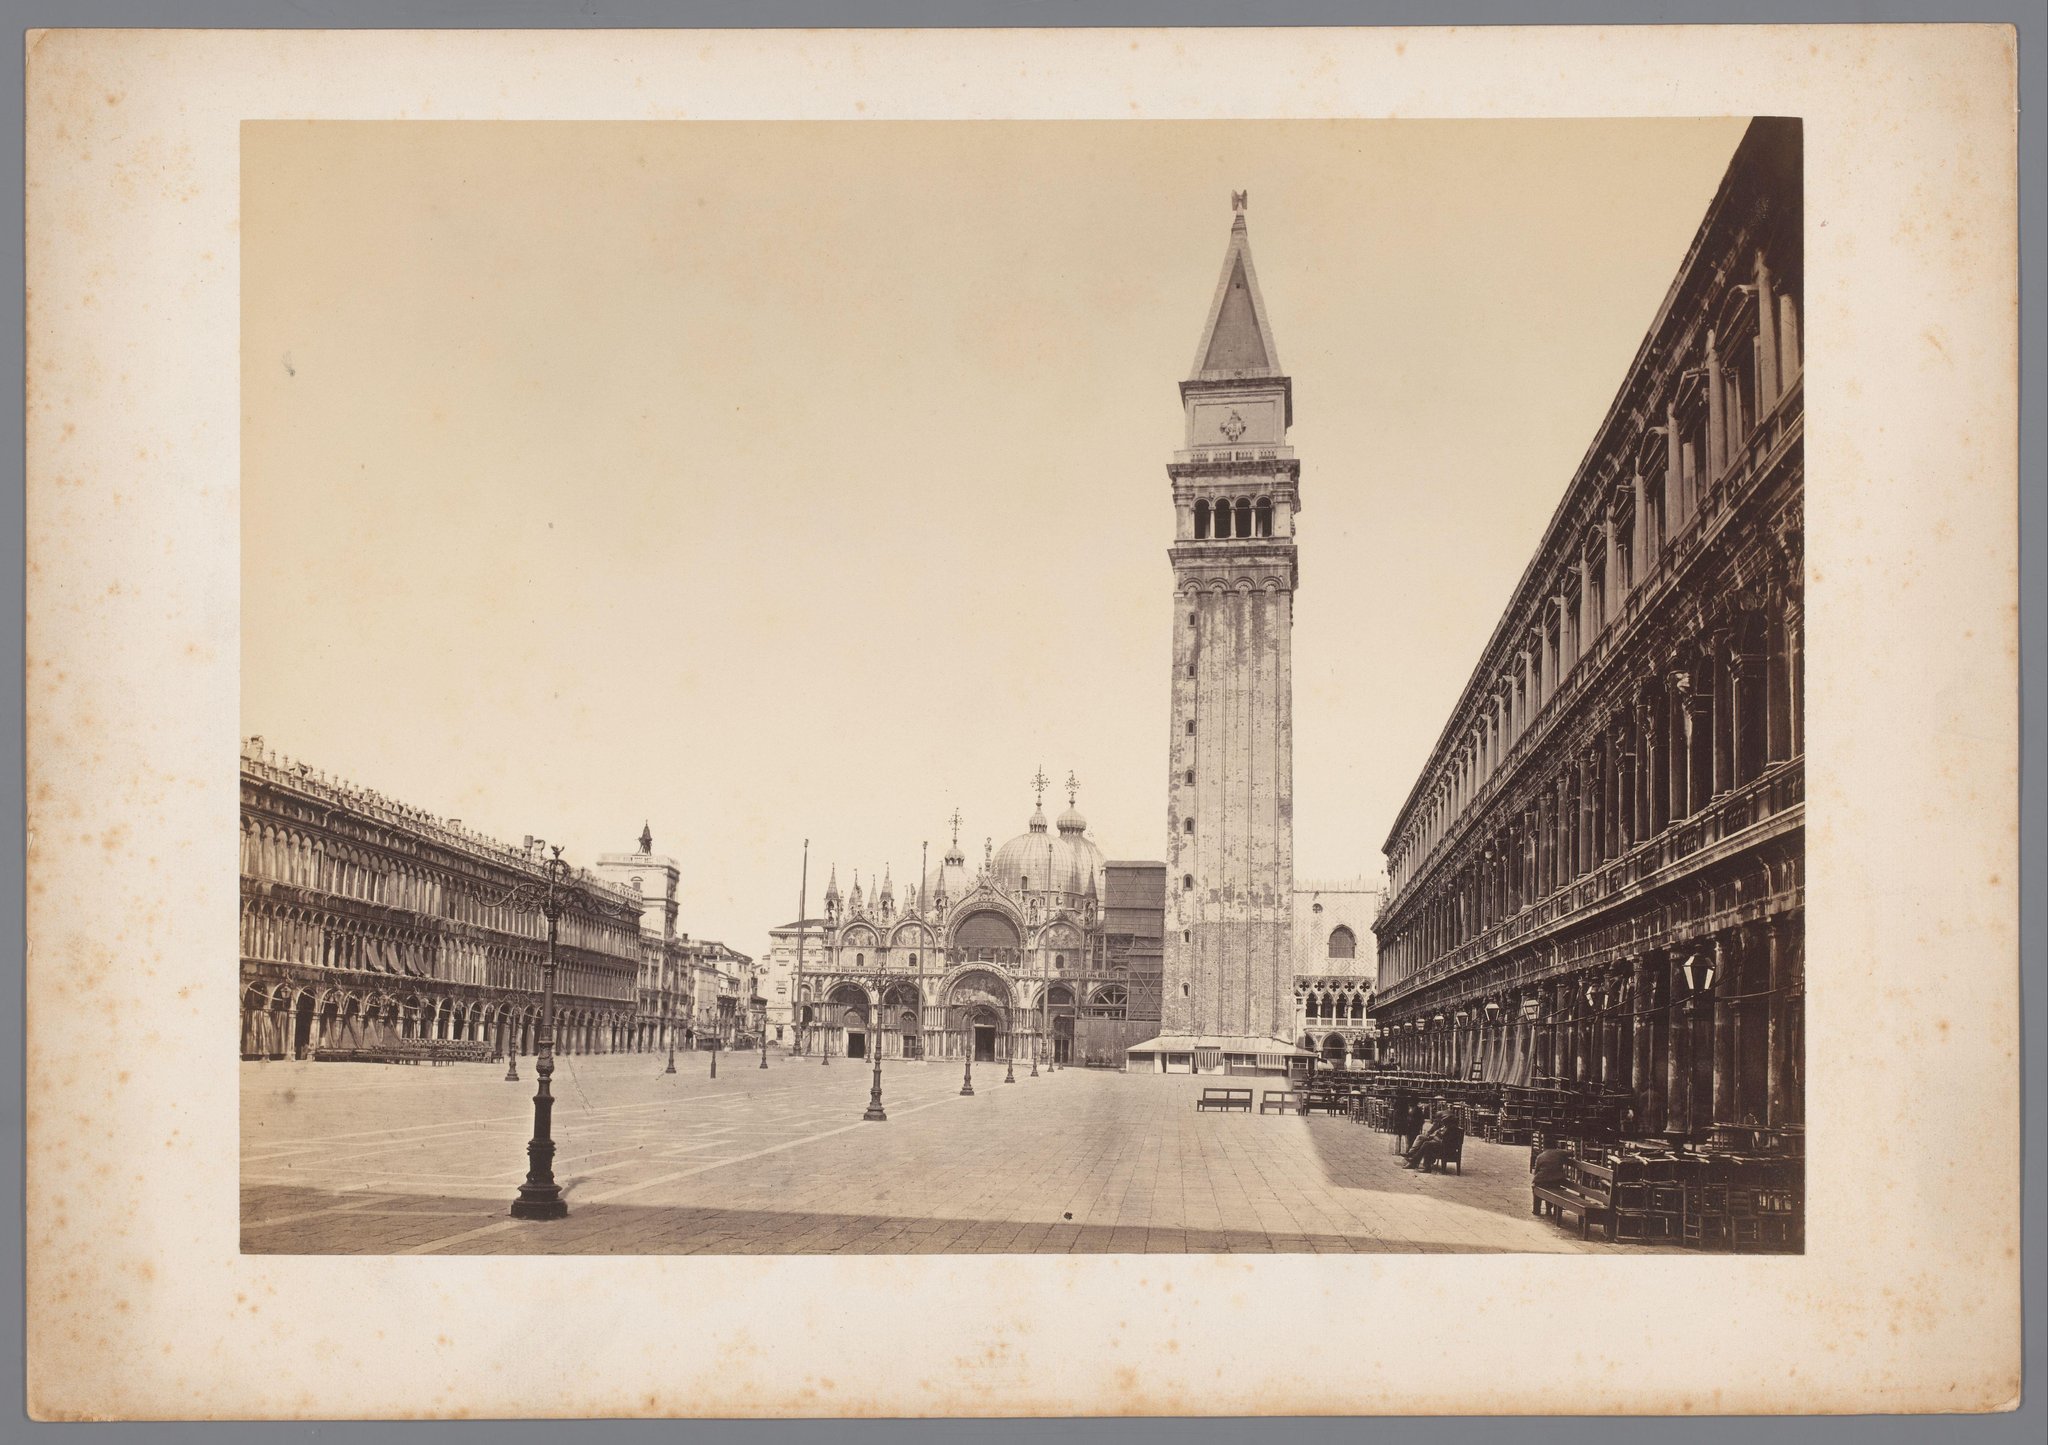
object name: photograph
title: Piazza di S. Marco dal Palazzo Reale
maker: carlo ponti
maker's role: fotograaf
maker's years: 1820-1893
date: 1850-1920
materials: cardboard, paper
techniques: albumen print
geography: venice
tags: parts of church exterior and annexes: campanile, square, place, circus, etc., palace, church (exterior)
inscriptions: inscription: ‘A gauche le Procuratie vecchie par Pietro Lombardo,/ (...)’, inscription: ‘(Deposé)’